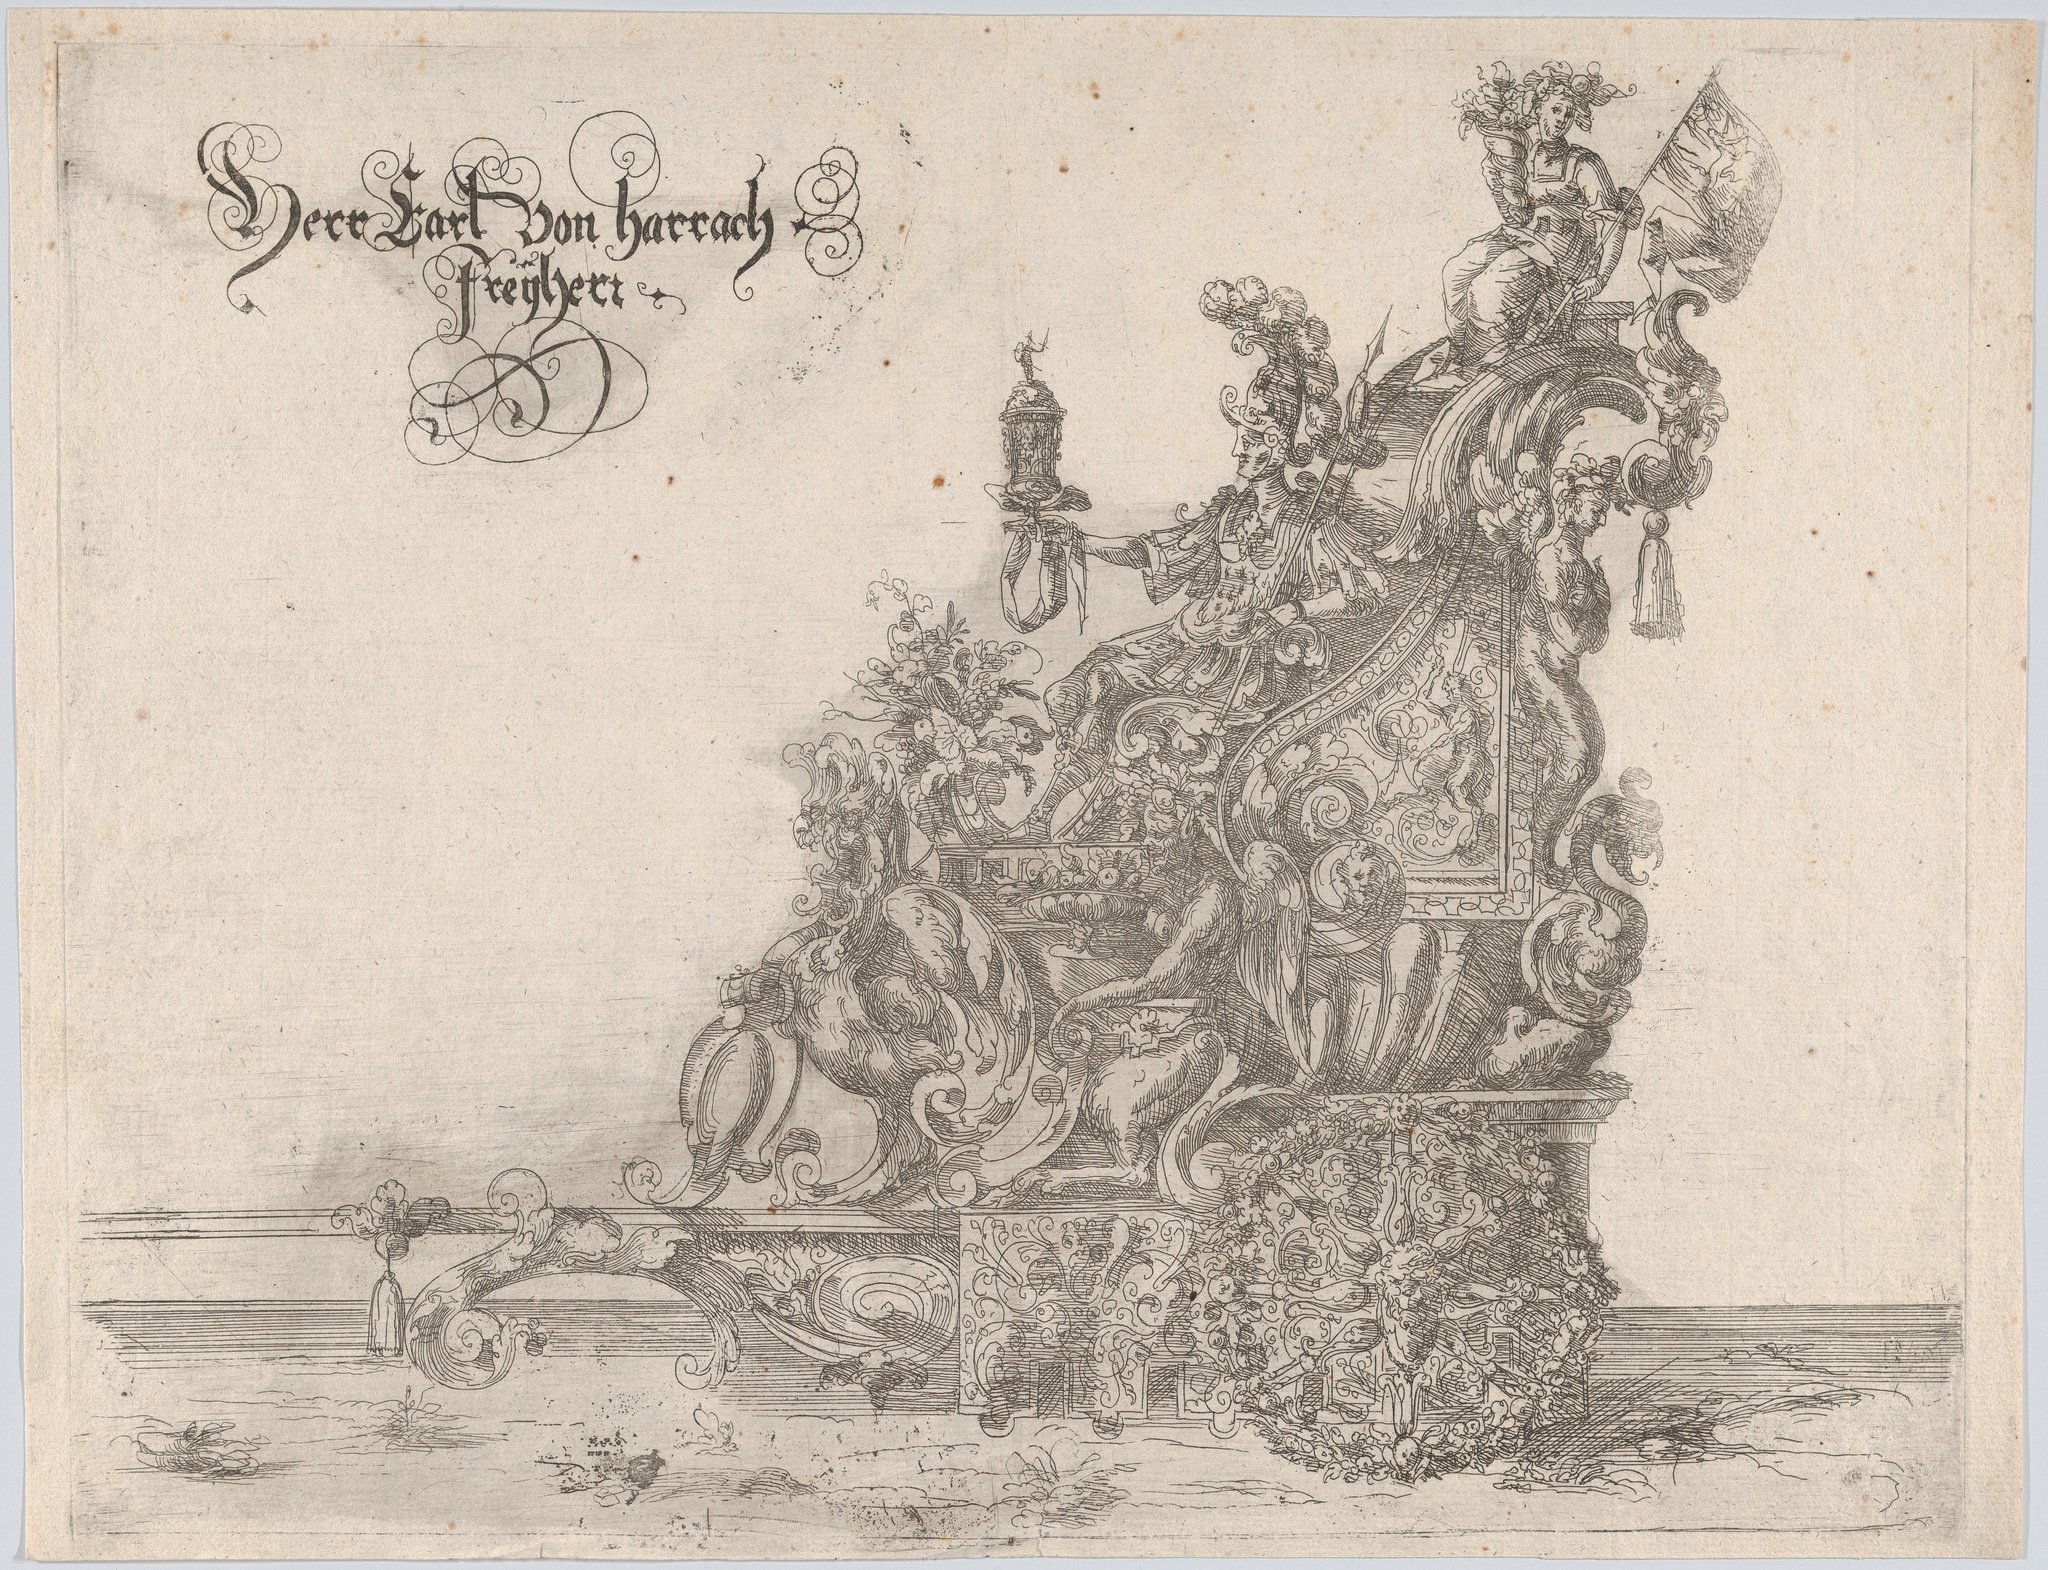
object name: print, fete, ornament architecture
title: Procession, with a male and female figure seated on a float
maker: anonymous, german, 16th century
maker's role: artist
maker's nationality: german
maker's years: 1500-1600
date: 1501-1600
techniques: etching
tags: women,chariots